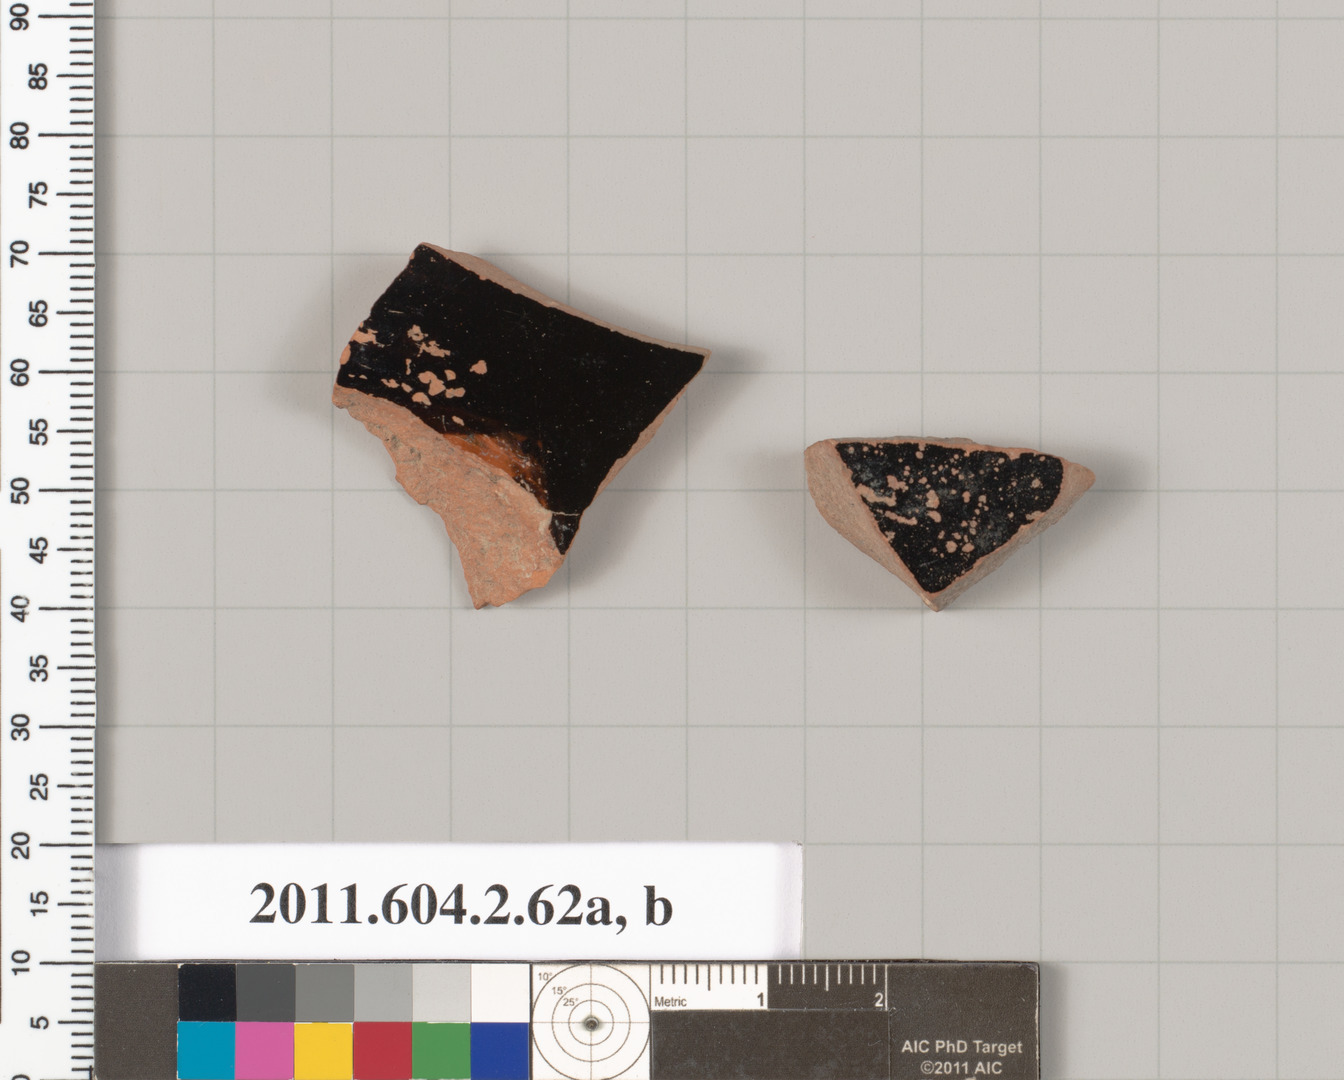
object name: pot fragment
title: Terracotta fragments of pots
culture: greek, attic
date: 534-468 BCE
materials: terracotta